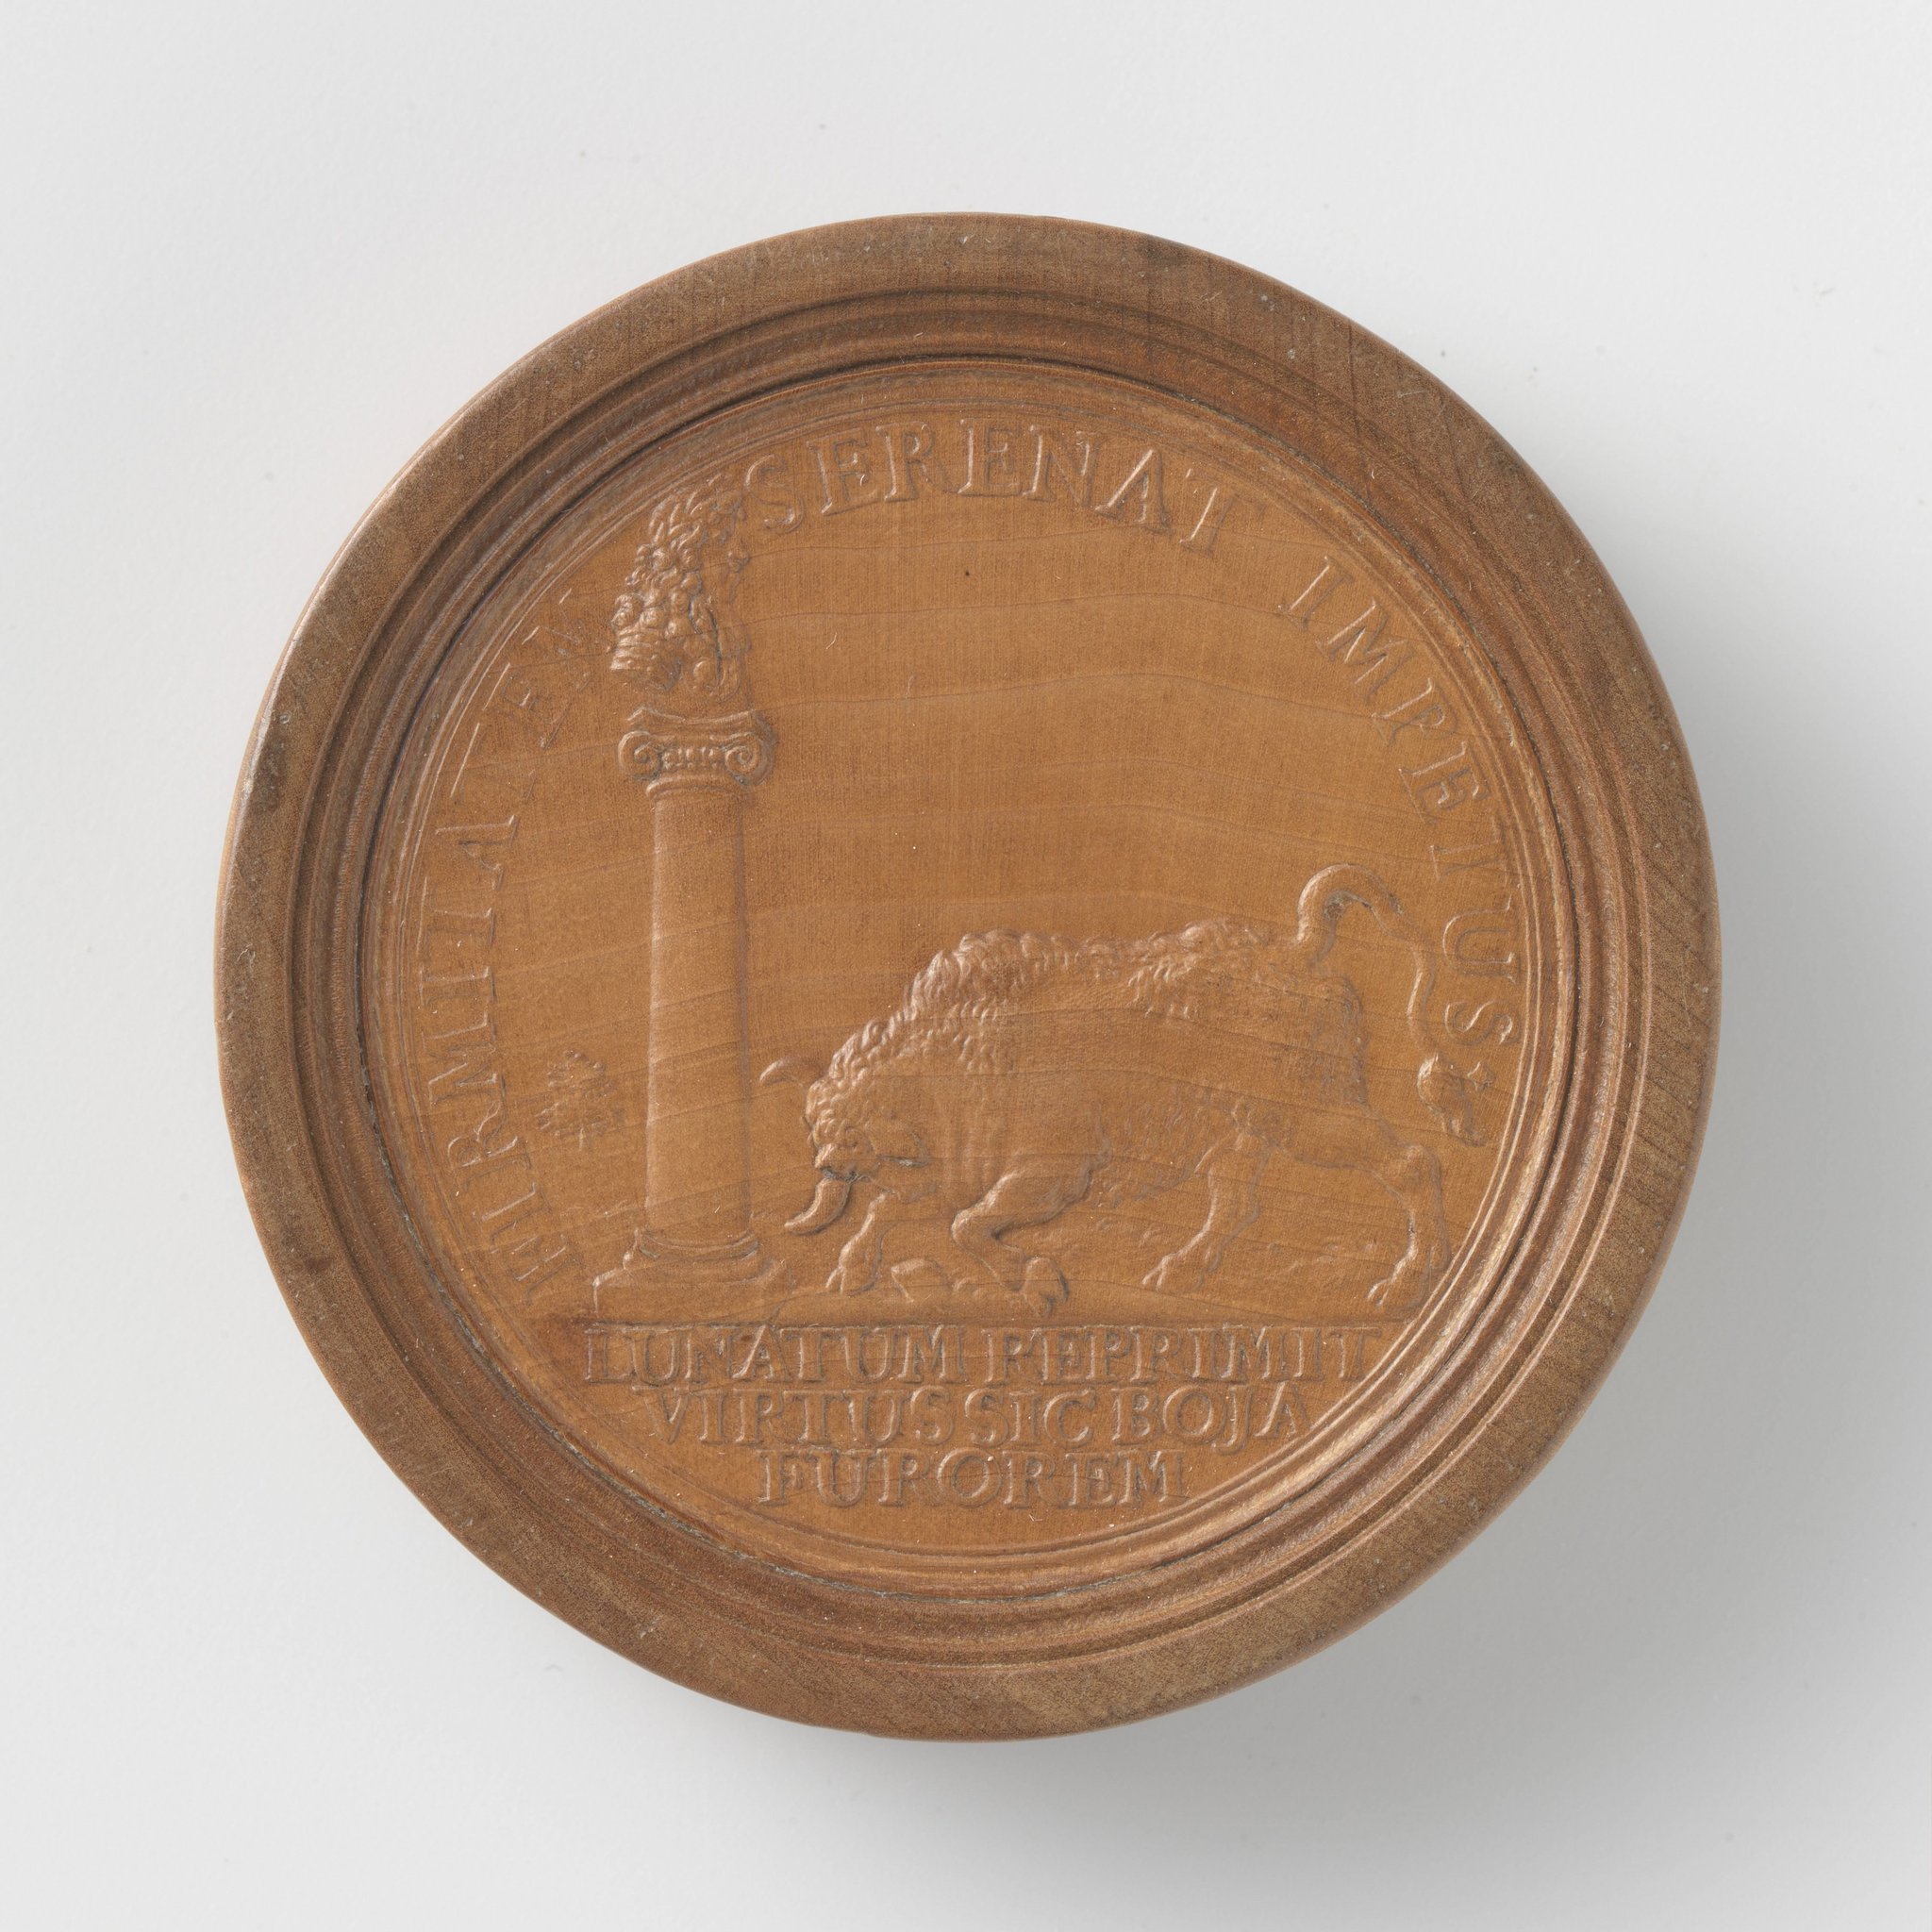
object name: relief sculpture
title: Snijwerk in reliëf van stier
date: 1675-1700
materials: wood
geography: germany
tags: slag bij mohacs (1687)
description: Afbeelding van een stier en zuil met buste. Op de achterkant een veldslag. Naar aanleiding van de overwinning op de Ottomaanse Turken onder sultan Mehmet IV door het Habsburgse leger van keizer Leopold I in de Slag bij Mohács (1687). Opschrift 'FIRMITATEM SERENAT IMPETUS' en 'LUNATUM REPRIMIT VIRTUS SIC BOJA FUROREM'. Op de achterkant 'CONSOSIA MINI ET VINCIMINI & QUIA HIC EST EMANUEL. Es 7 (8) en MOHAZIANUM BAVARICAE STRENUITATIS AERE AUROQUE PERENNIORIS MONUMENTON. 1687.